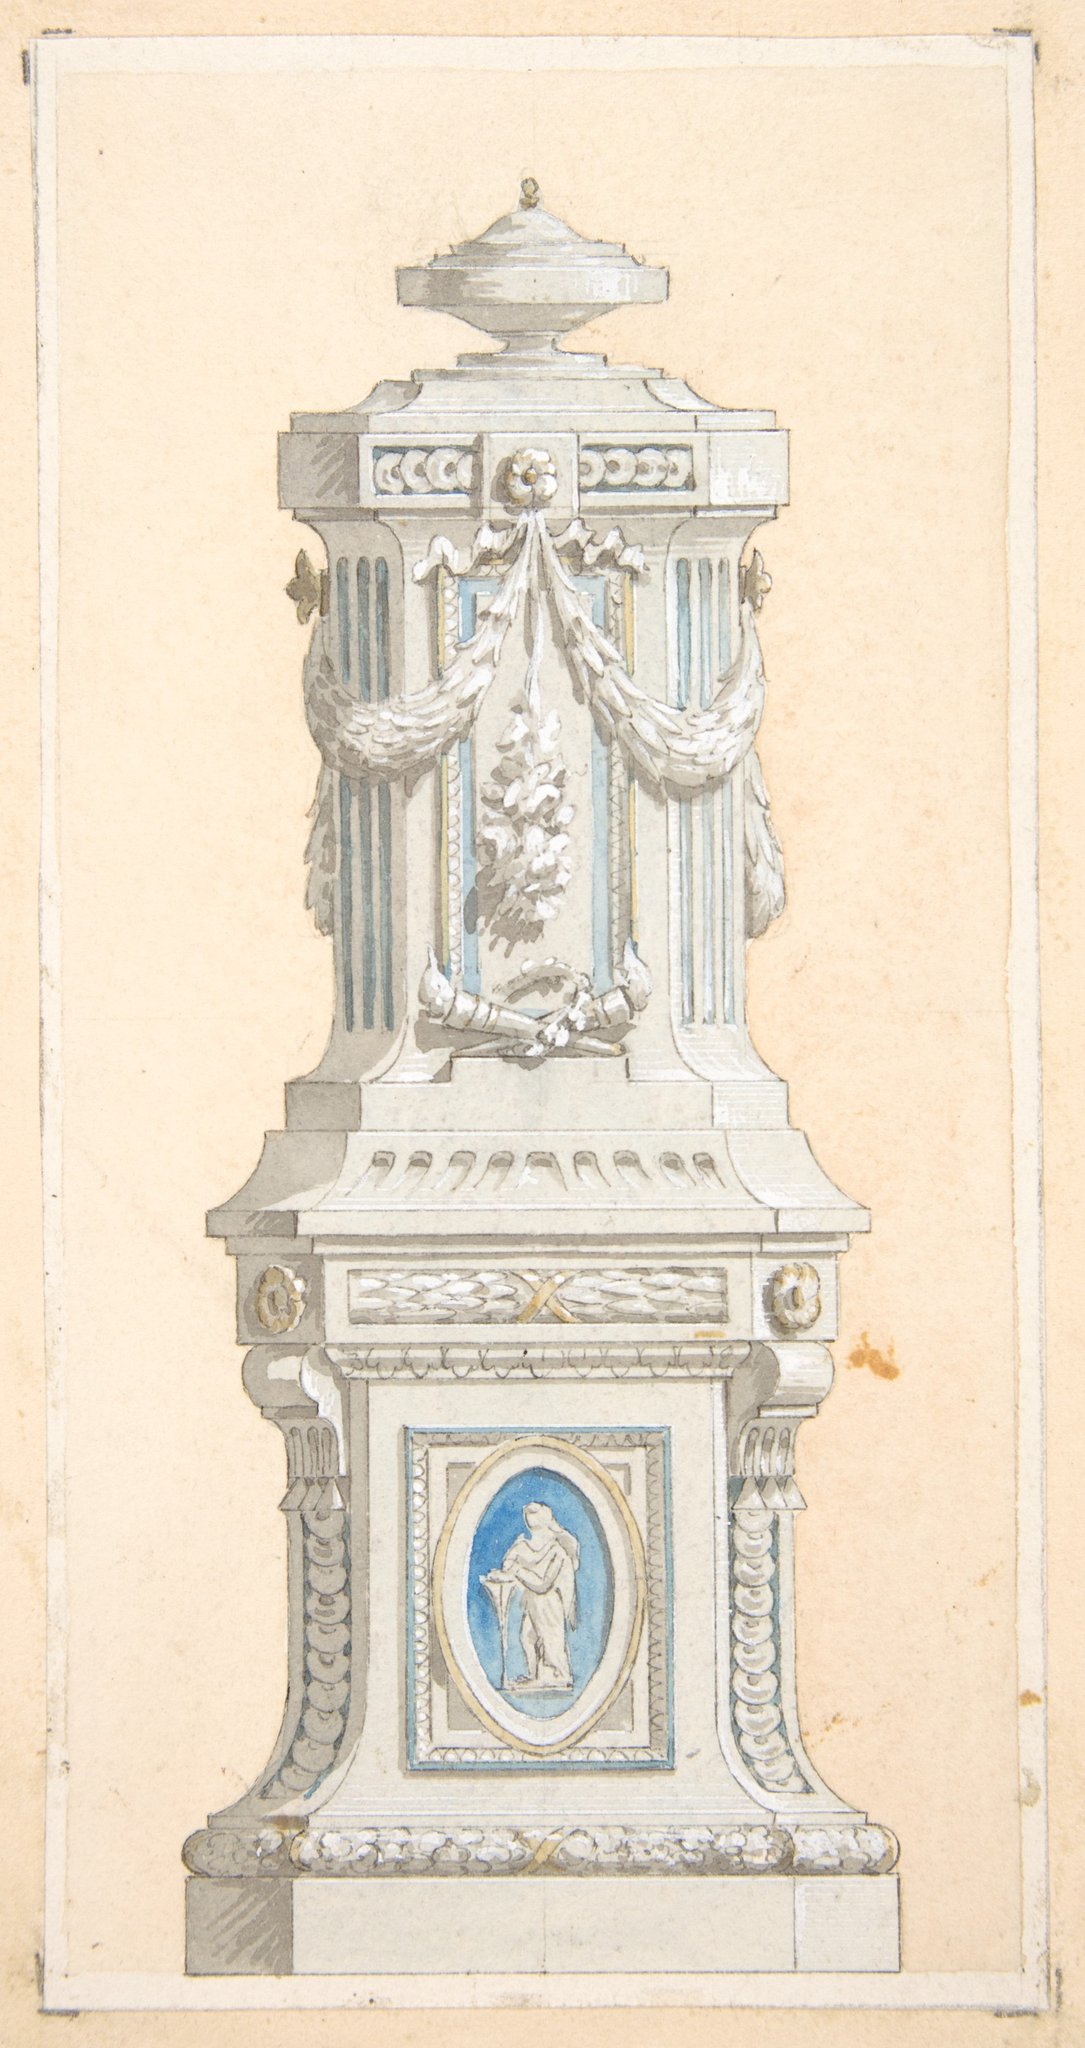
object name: drawing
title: Design for an ornamented stone pedastal surmounted by an urn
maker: jules-edmond-charles lachaise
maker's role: artist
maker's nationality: french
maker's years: 1897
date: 1830-1897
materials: graphite, paper, watercolor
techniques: heightening